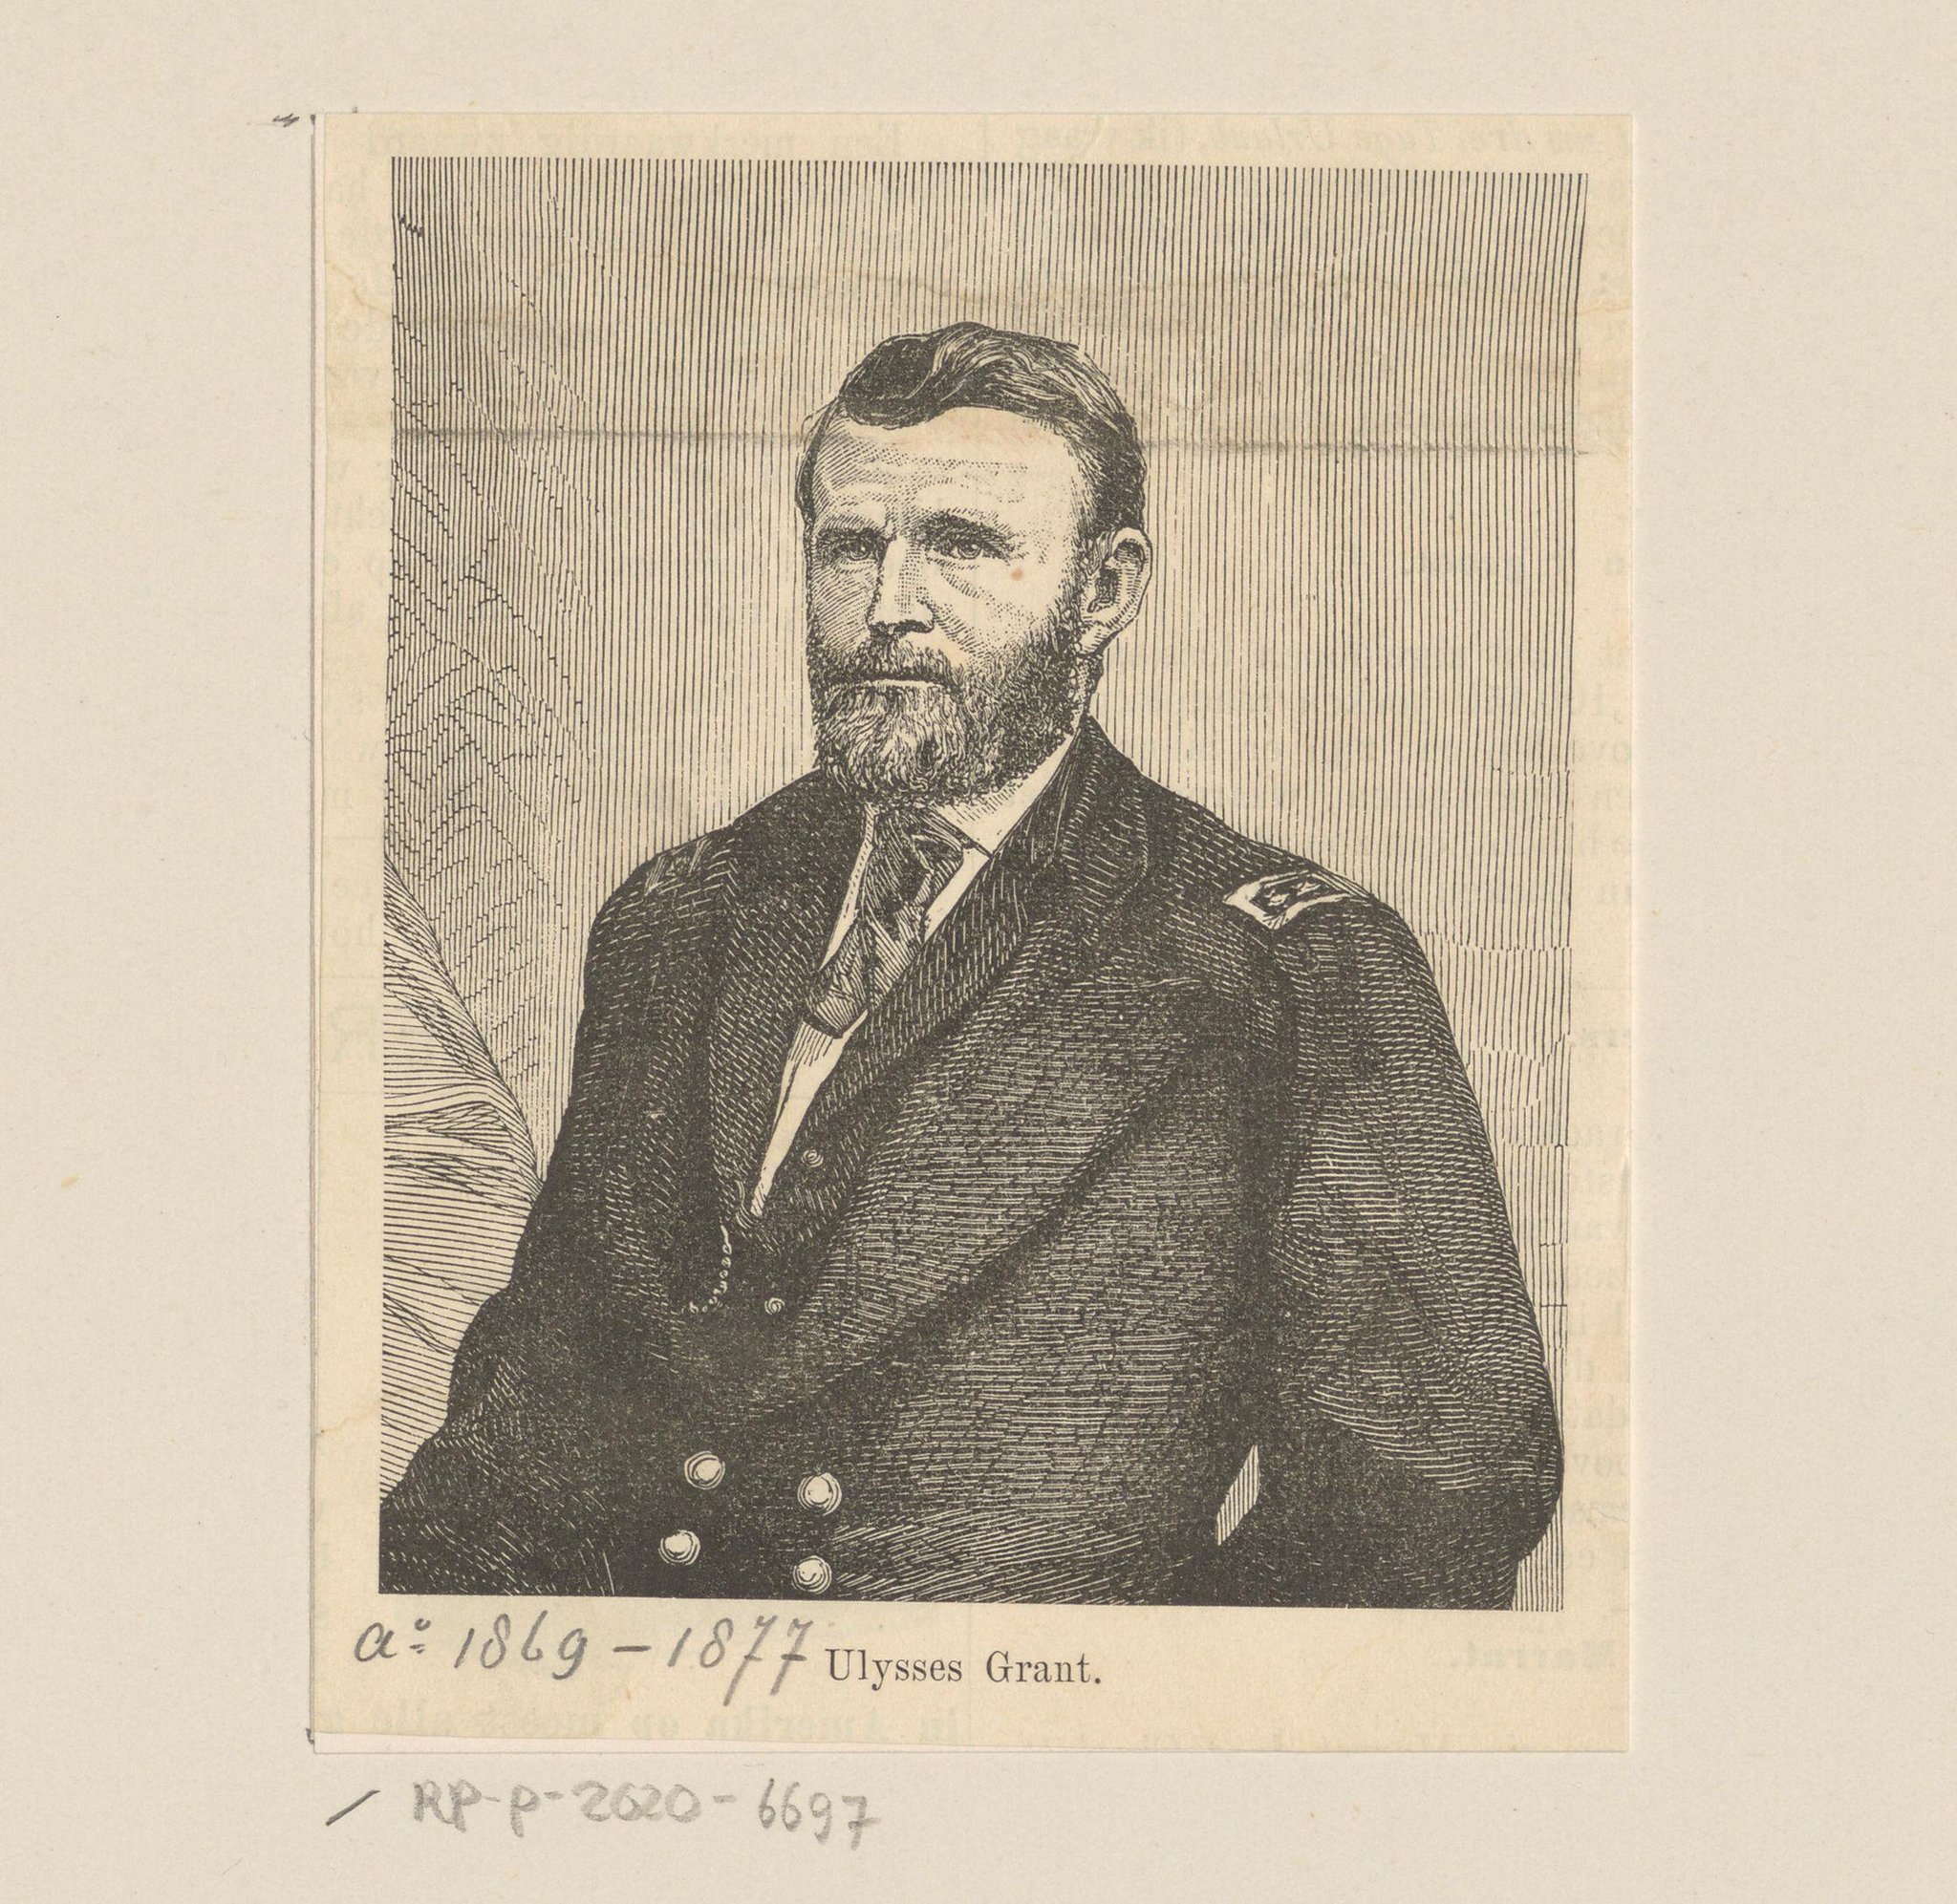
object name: print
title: Portret van Ulysses Simpson Grant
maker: Anonymous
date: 1869-1930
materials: paper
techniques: letterpress printing, engraving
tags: president ~ head of republic, historical persons